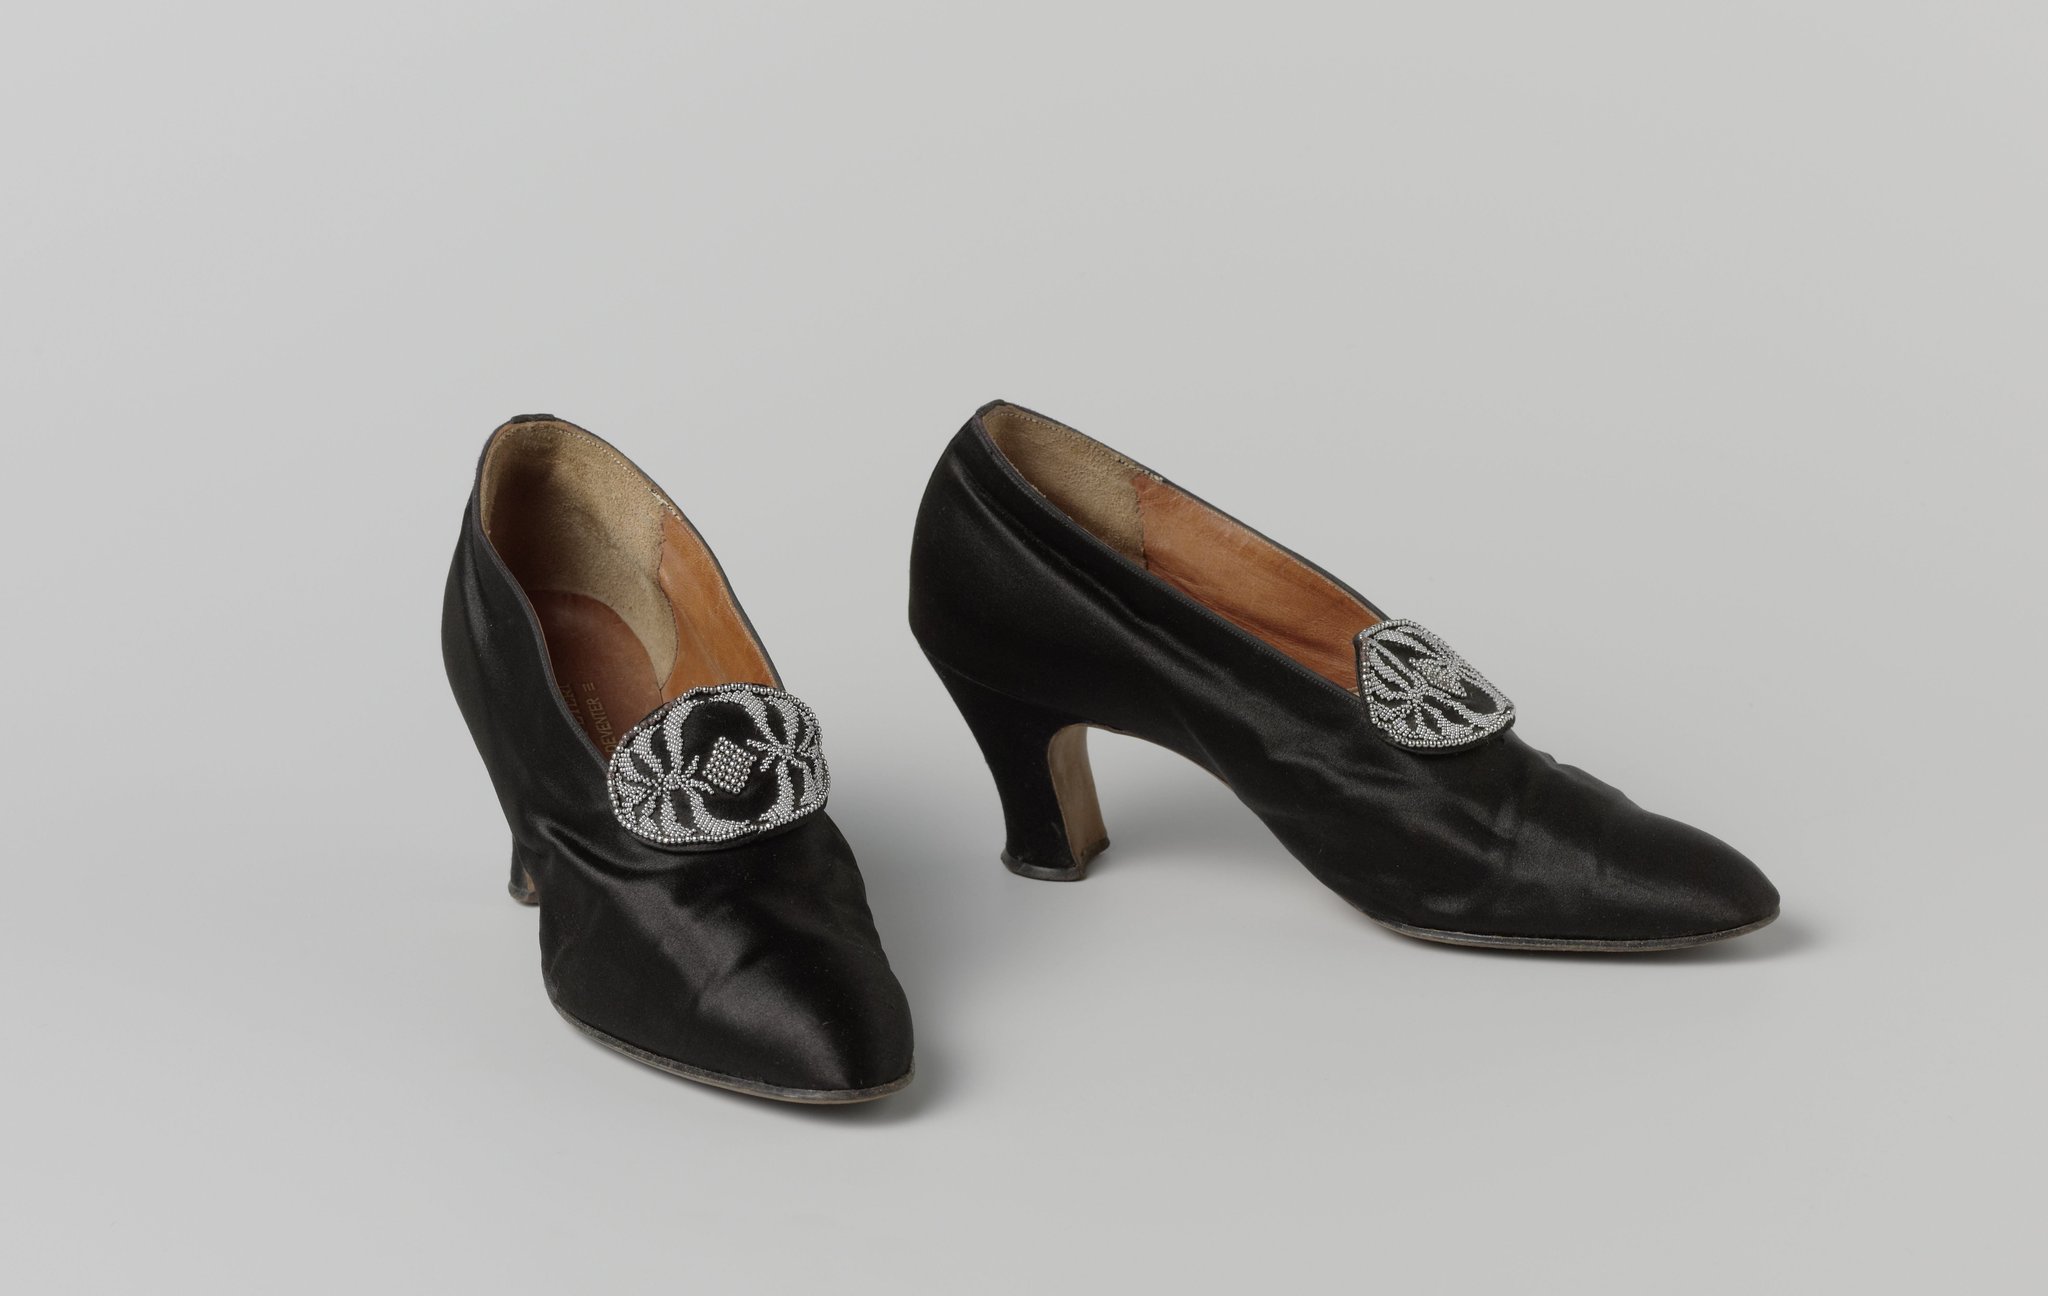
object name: pump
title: Linkerschoen (pump) van zwarte zijde met ovale gesp van zwarte zijde met geslepen stalen kralen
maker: h. peteri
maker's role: schoenmaker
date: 1925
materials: paint, silk, steel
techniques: grinding, printing, tanning, weave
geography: deventer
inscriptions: mark: ‘Fa. H. Peteri/ Deventer’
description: Schoen van zwarte zijde met ovale gesp van zwarte zijde met geslepen stalen kralen. Pump met hoge wreef en halfhoge hak. De zwarte zijde is gevoerd met leer en de pump heeft een leren binnenzool, leren zool en hak. Op de wreef is de schoen versierd met een ovale gesp van zwarte zijde met een rand van glanzend gepolijste stalen bolletjes en in het midden een ruit opgebouwd uit dezelfde bolletjes. Het patroon is symmetrisch opgebouwd uit accolades met bolletjes in het midden.